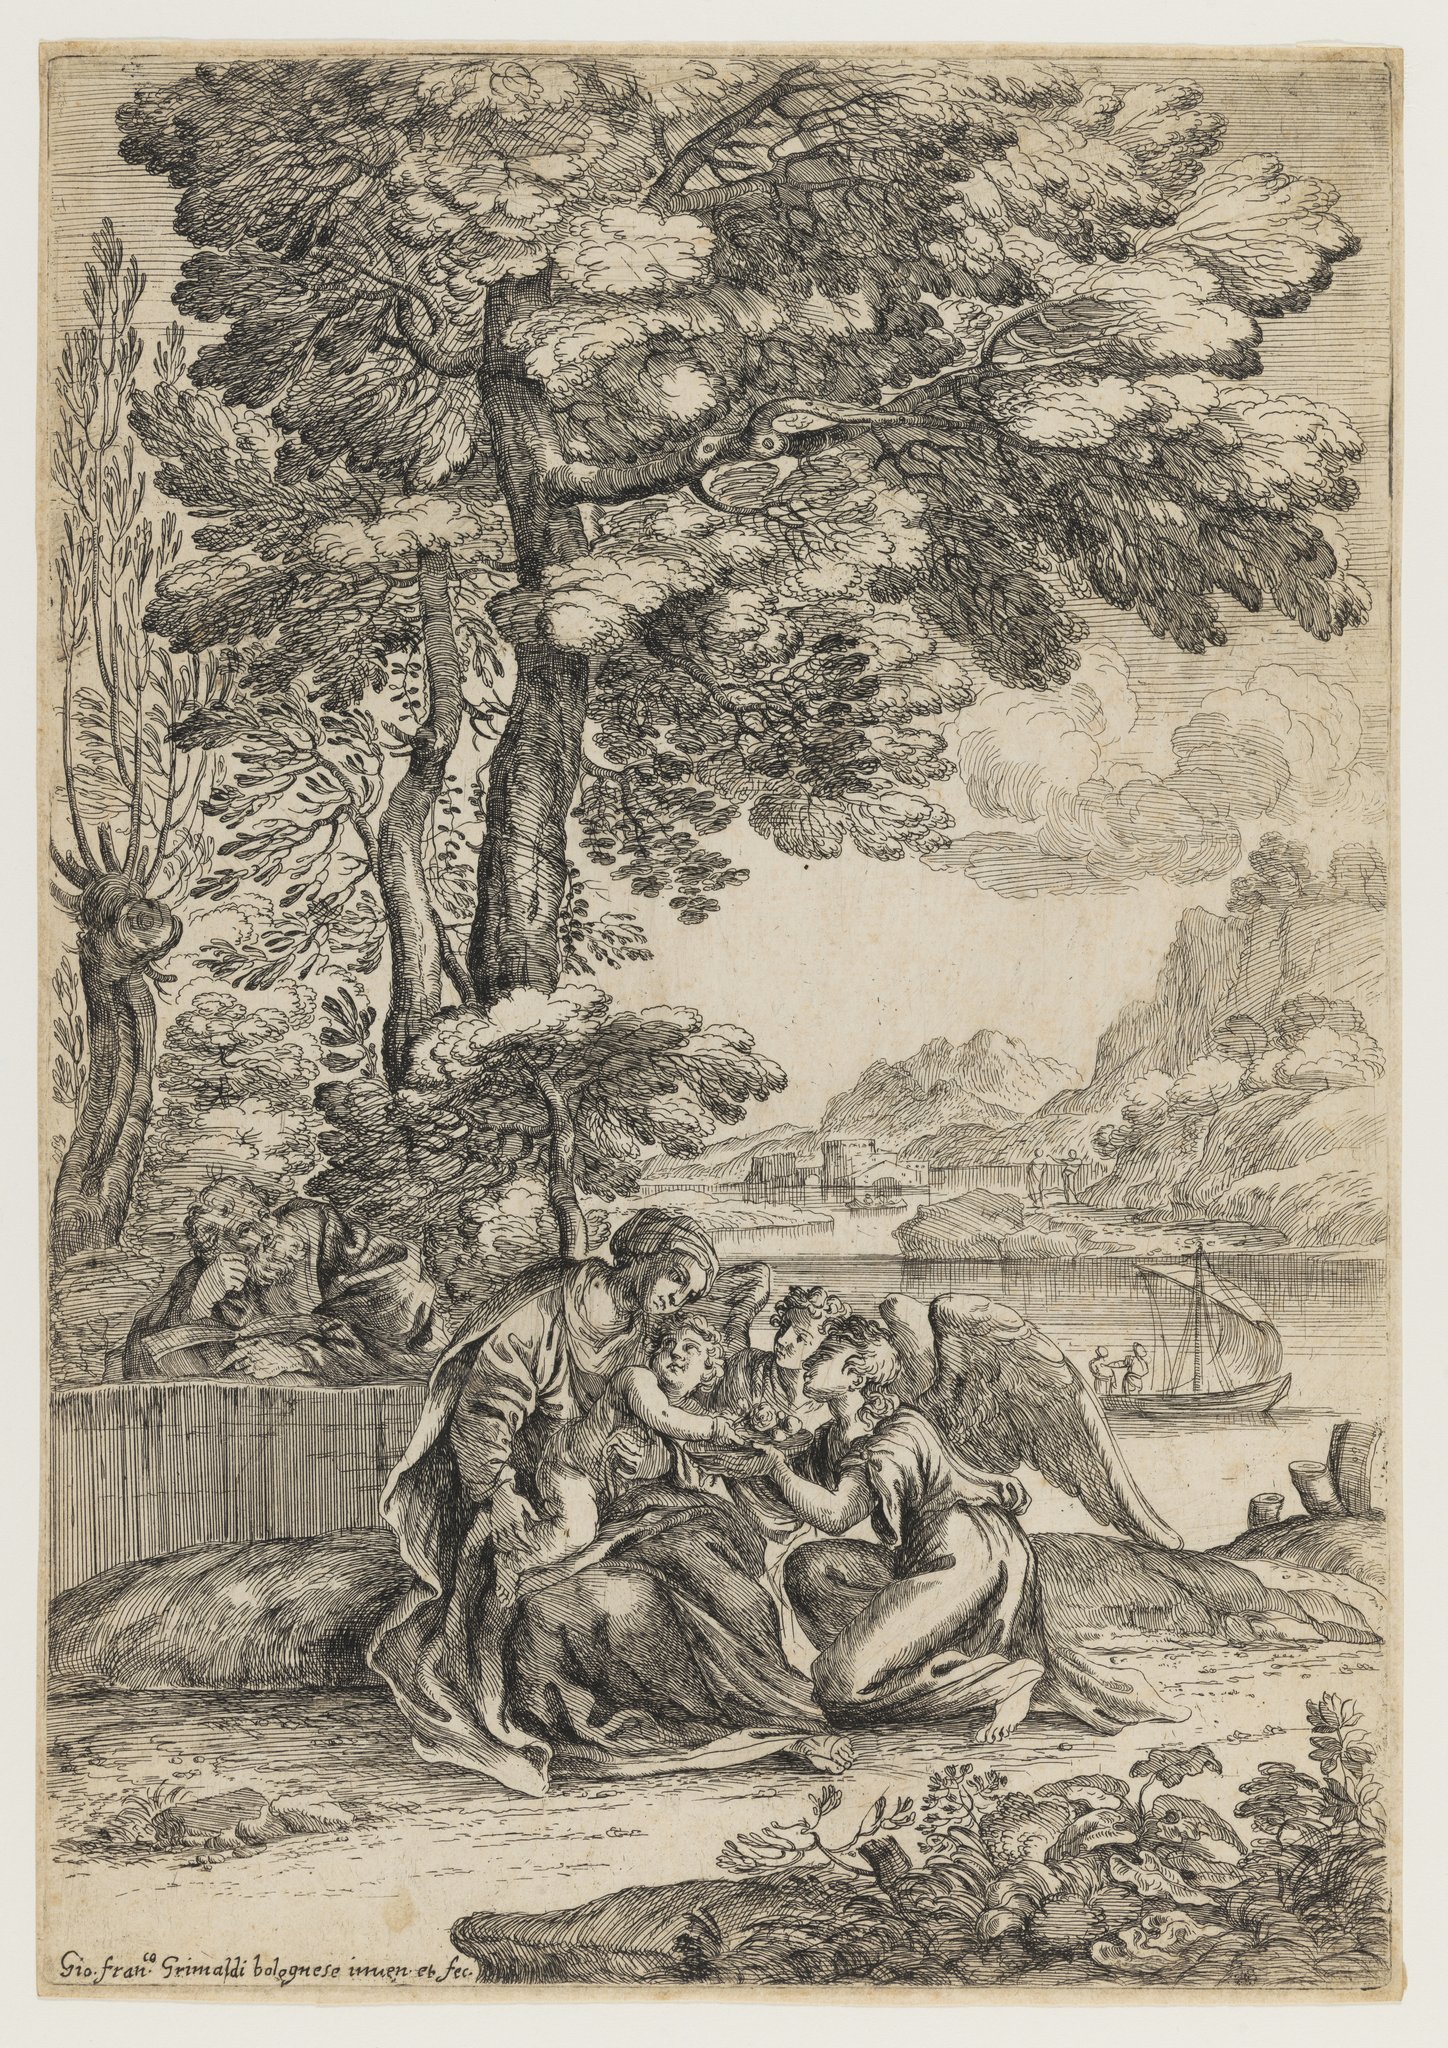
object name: print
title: The Holy Family on the Rest on the Flight into Egypt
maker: giovanni francesco grimaldi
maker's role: artist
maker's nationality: italian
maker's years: 1606-1680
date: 1630-1680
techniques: etching